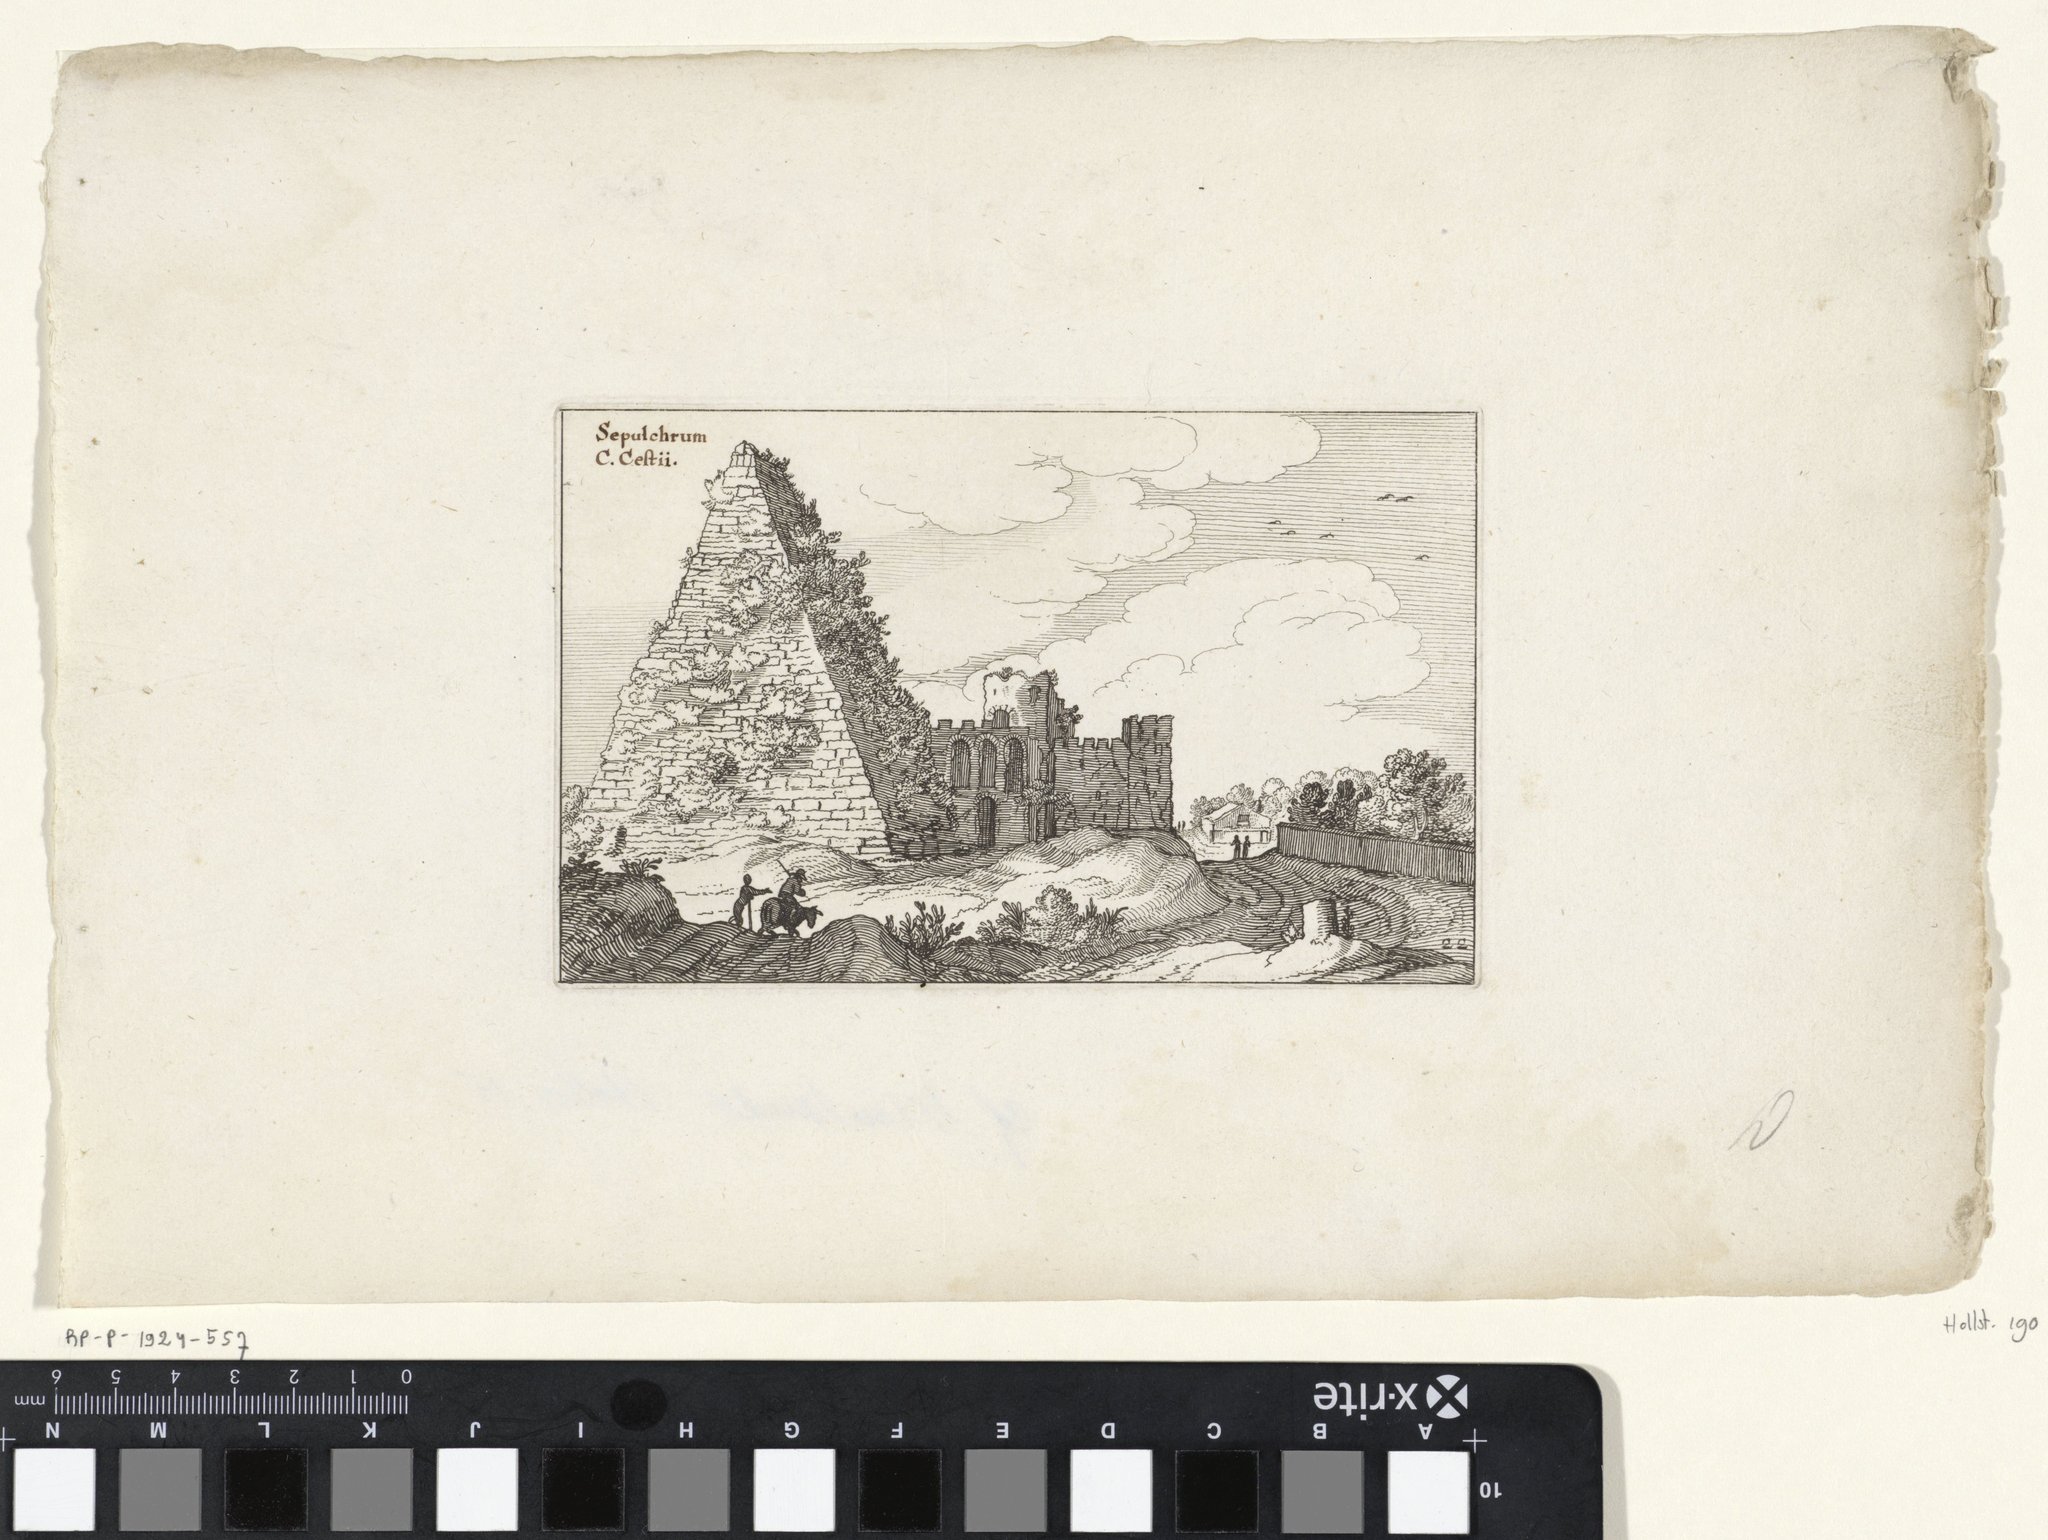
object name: print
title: Variae antiquitates Romanae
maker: claes jansz. visscher (ii)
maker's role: draughtsman, print maker, publisher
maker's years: 1586-1652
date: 1618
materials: paper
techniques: etching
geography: amsterdam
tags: landscape with ruins, rome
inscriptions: collector's mark: Lugt 2233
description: Gezicht op de piramide van Gaius Cestius in Rome, met op de voorgrond een man op een ezel en een wandelaar.